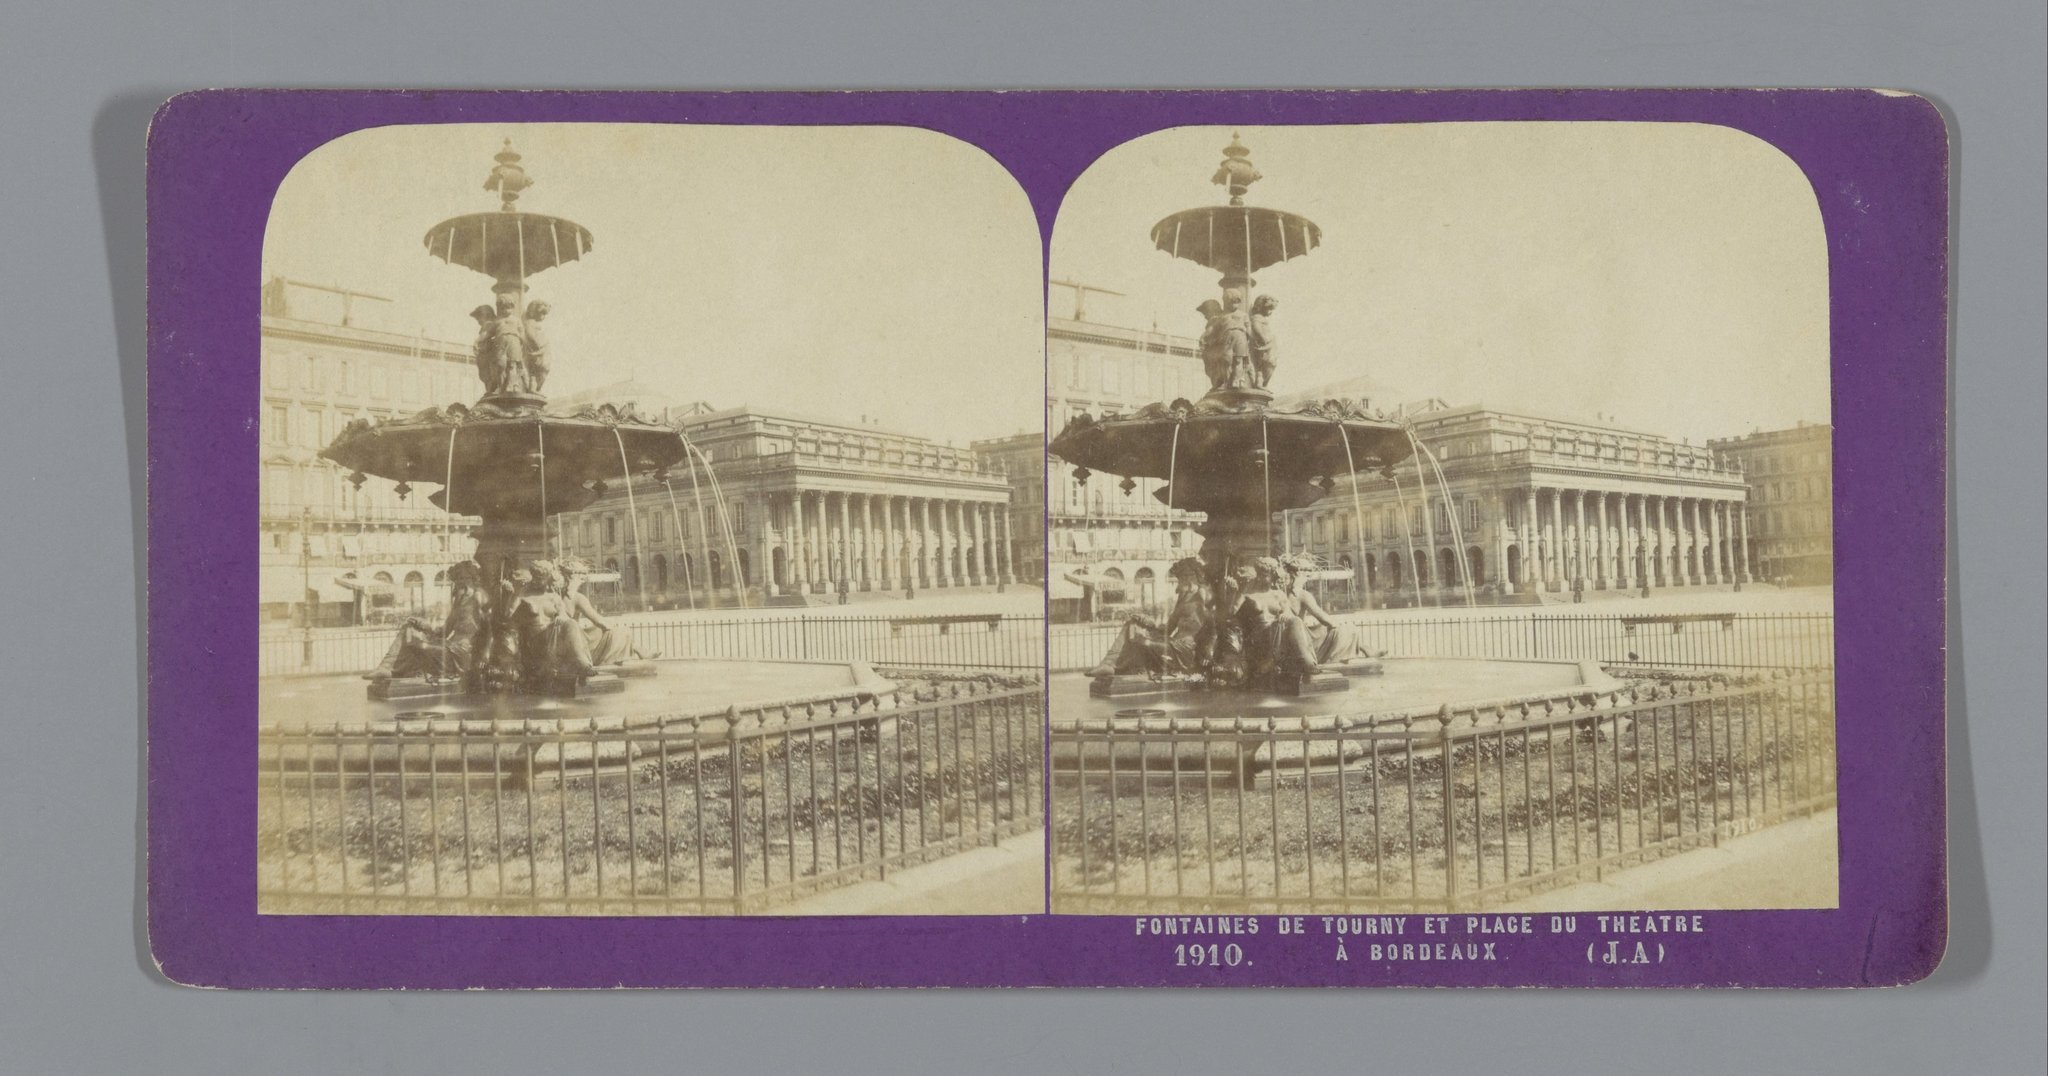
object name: stereograph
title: Fontein op het Place du Théâtre te Bordeaux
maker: jean andrieu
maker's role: fotograaf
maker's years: 1816-1872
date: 1862-1876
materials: cardboard, photographic support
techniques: albumen print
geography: bordeaux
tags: square, place, circus, etc., ornamental fountain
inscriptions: number: ‘1910.’